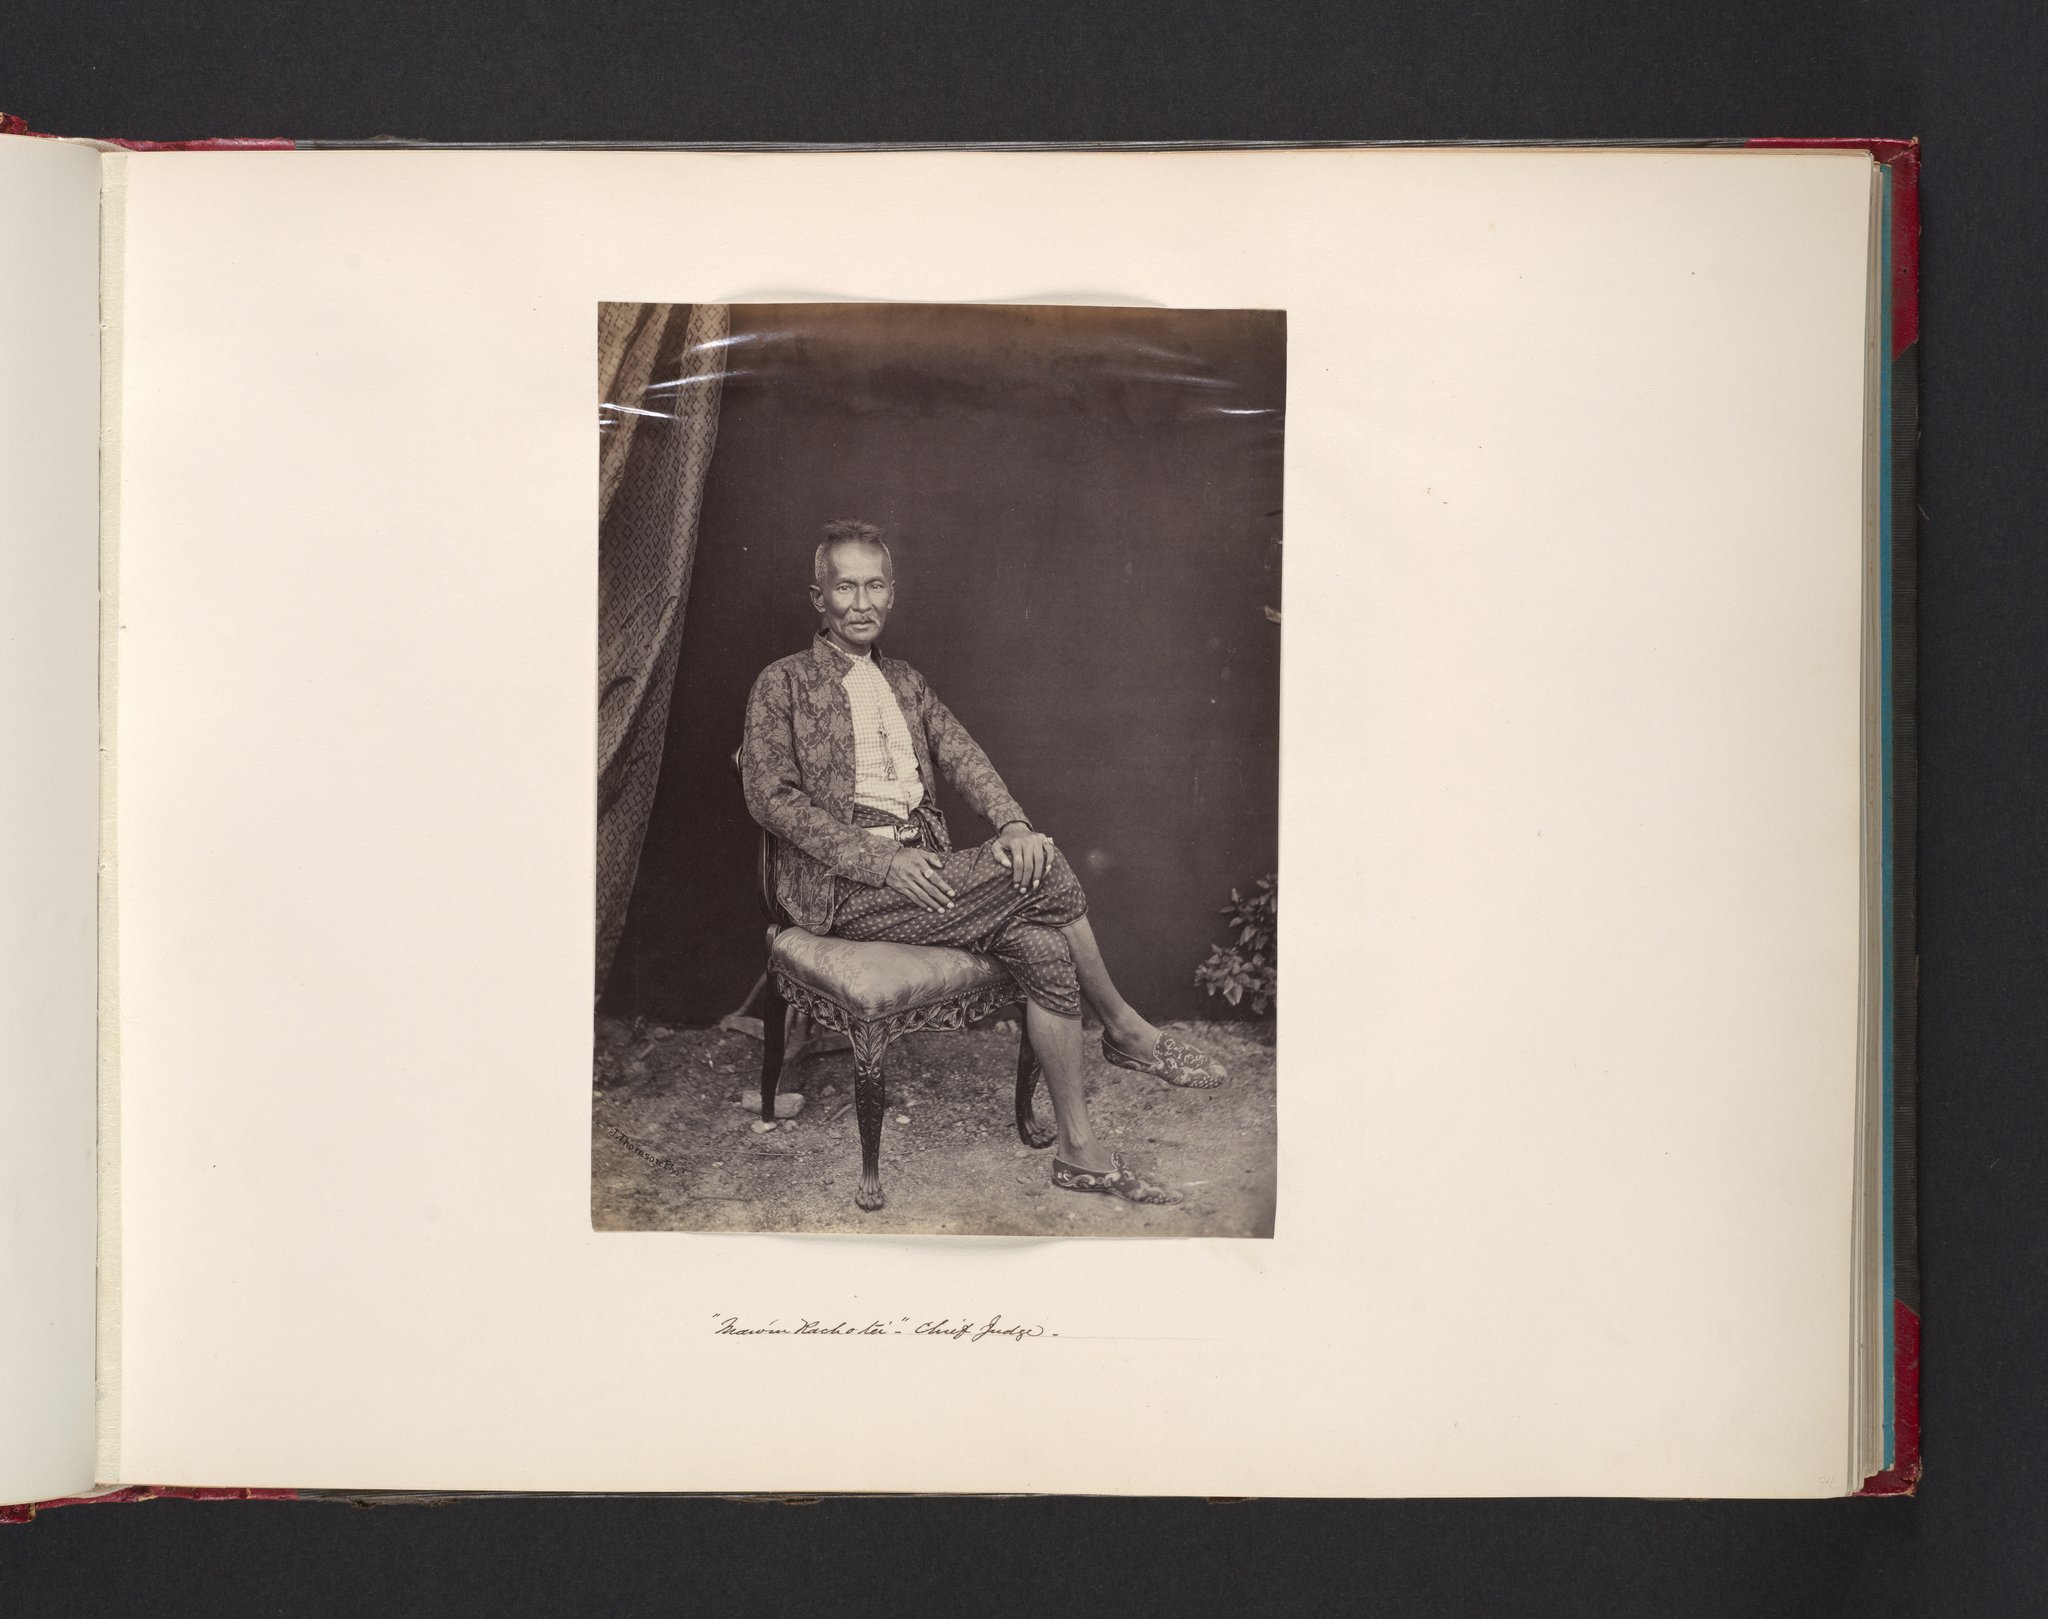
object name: photograph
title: [Chief Judge]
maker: john thomson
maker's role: artist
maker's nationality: british, scottish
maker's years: 1837-1921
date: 1865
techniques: albumen silver print, glass negative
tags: men,portraits